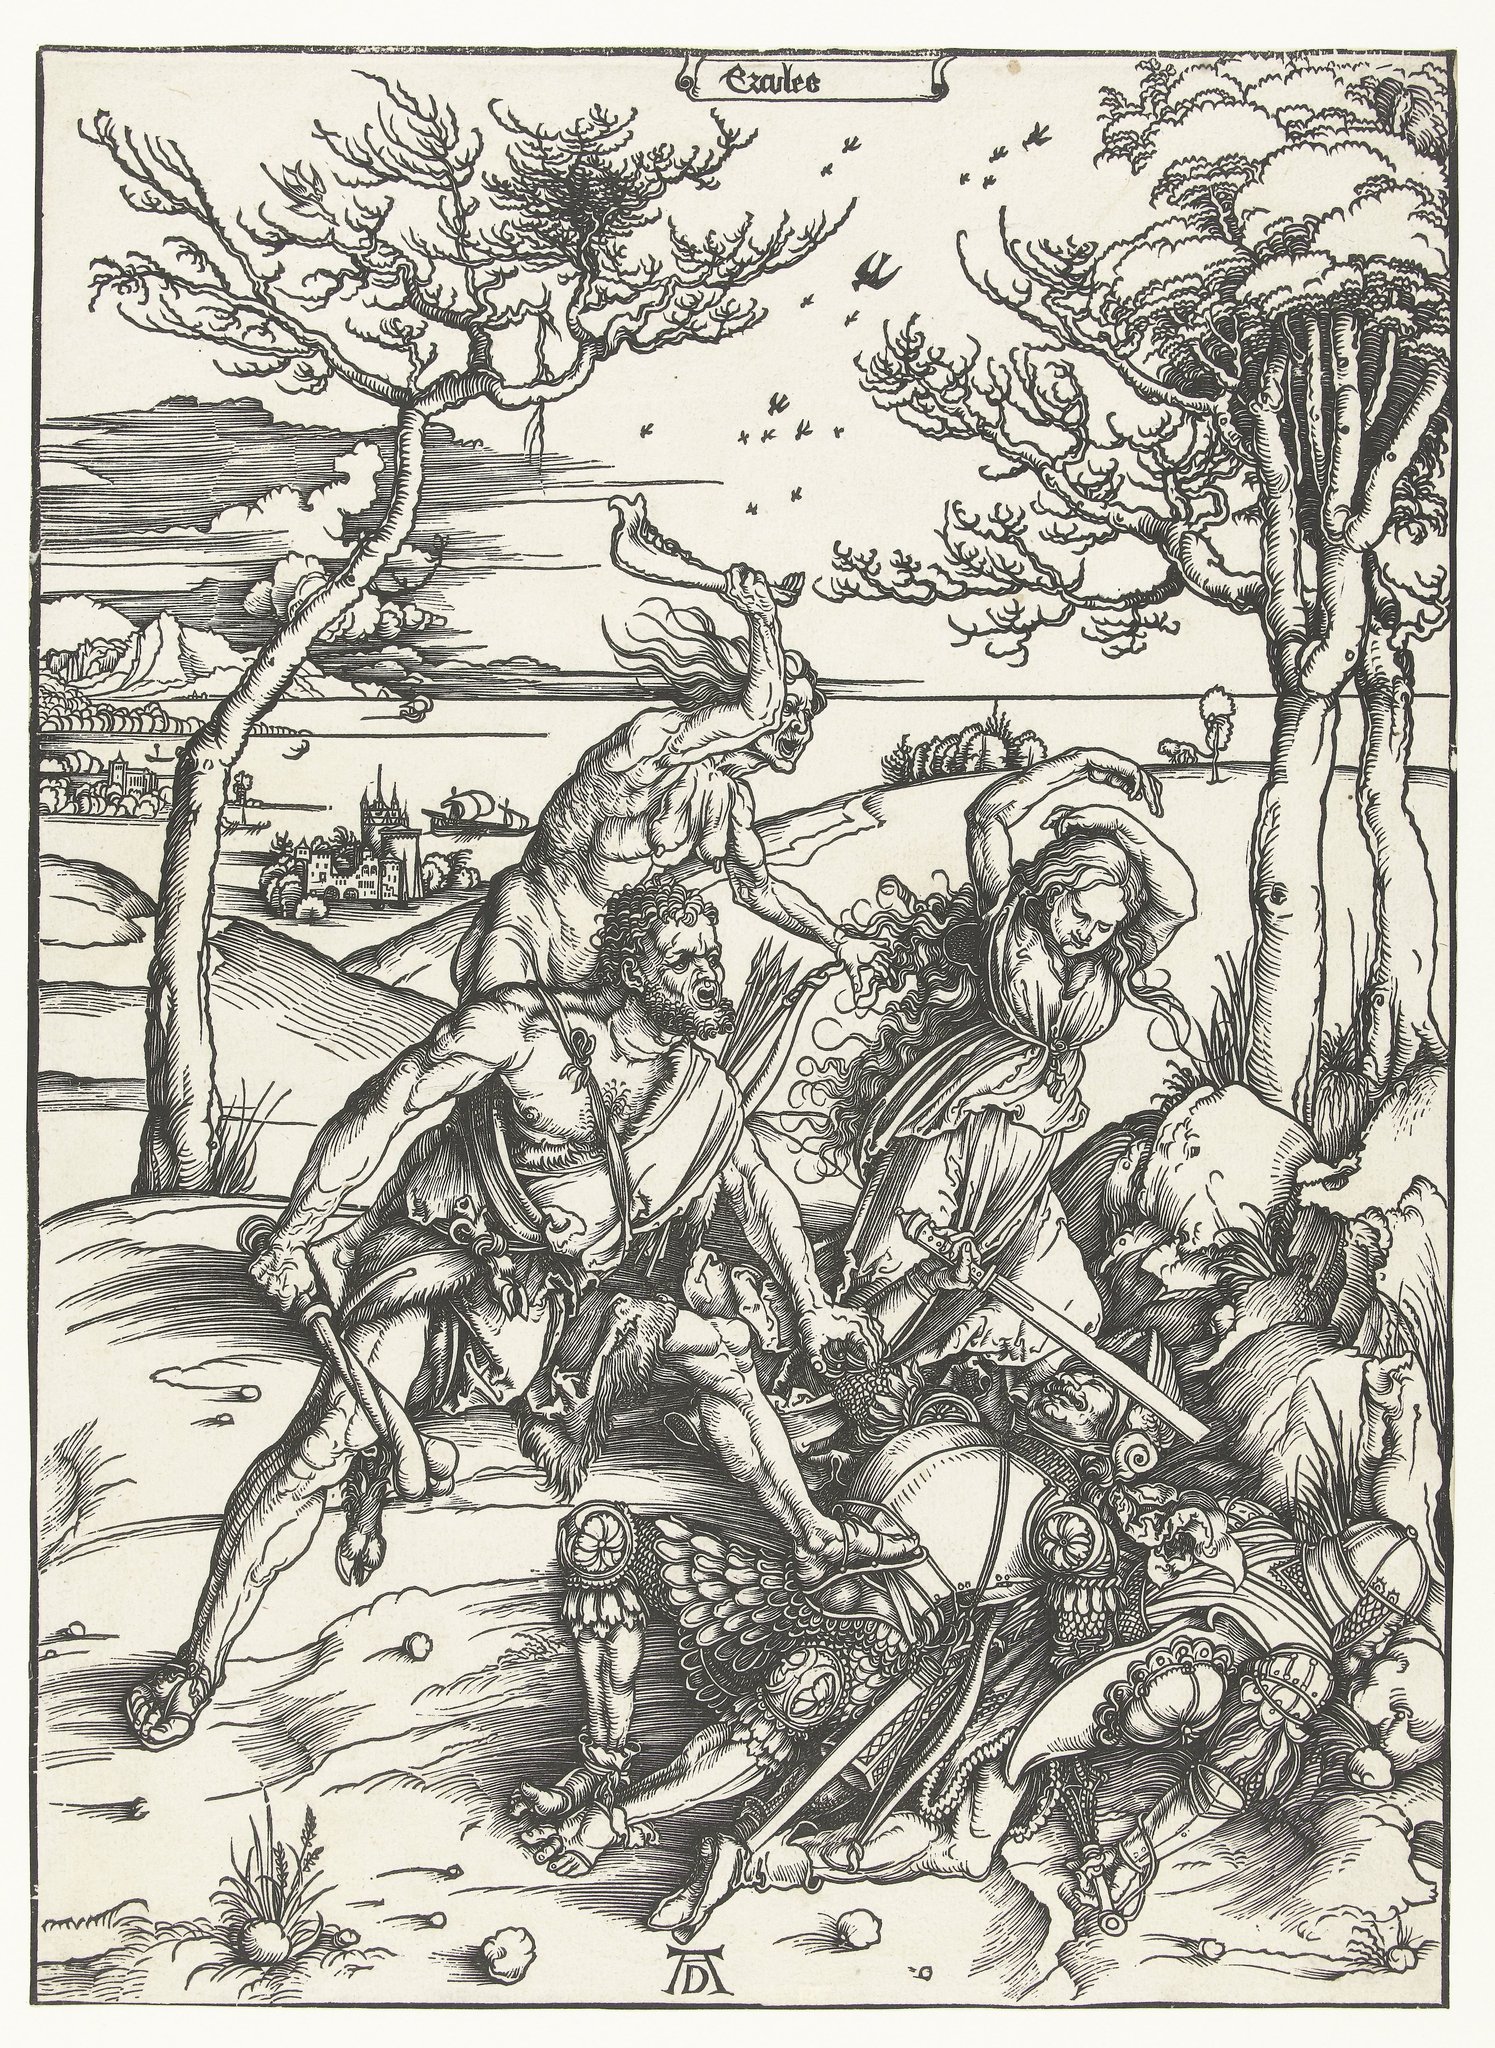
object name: print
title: Eracles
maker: albrecht dürer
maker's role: draughtsman, painter, print maker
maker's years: 1471-1528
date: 1494-1498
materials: paper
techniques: woodcut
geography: nuremberg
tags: hercules' fight with the molionides, the siamese twins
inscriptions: collector's mark: Lugt 240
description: Hercules verslaat met zijn knots de zogenoemde Molioniden: de tweeling Eurytus en Kteatus, die hun oom Augias bijstonden in zijn strijd tegen Hercules. Twee vrouwen staan bij Heracles en de twee neven: een mooie jongedame met lang krullend haar en een naakte oude vrouw met een kaakbeen in de hand.